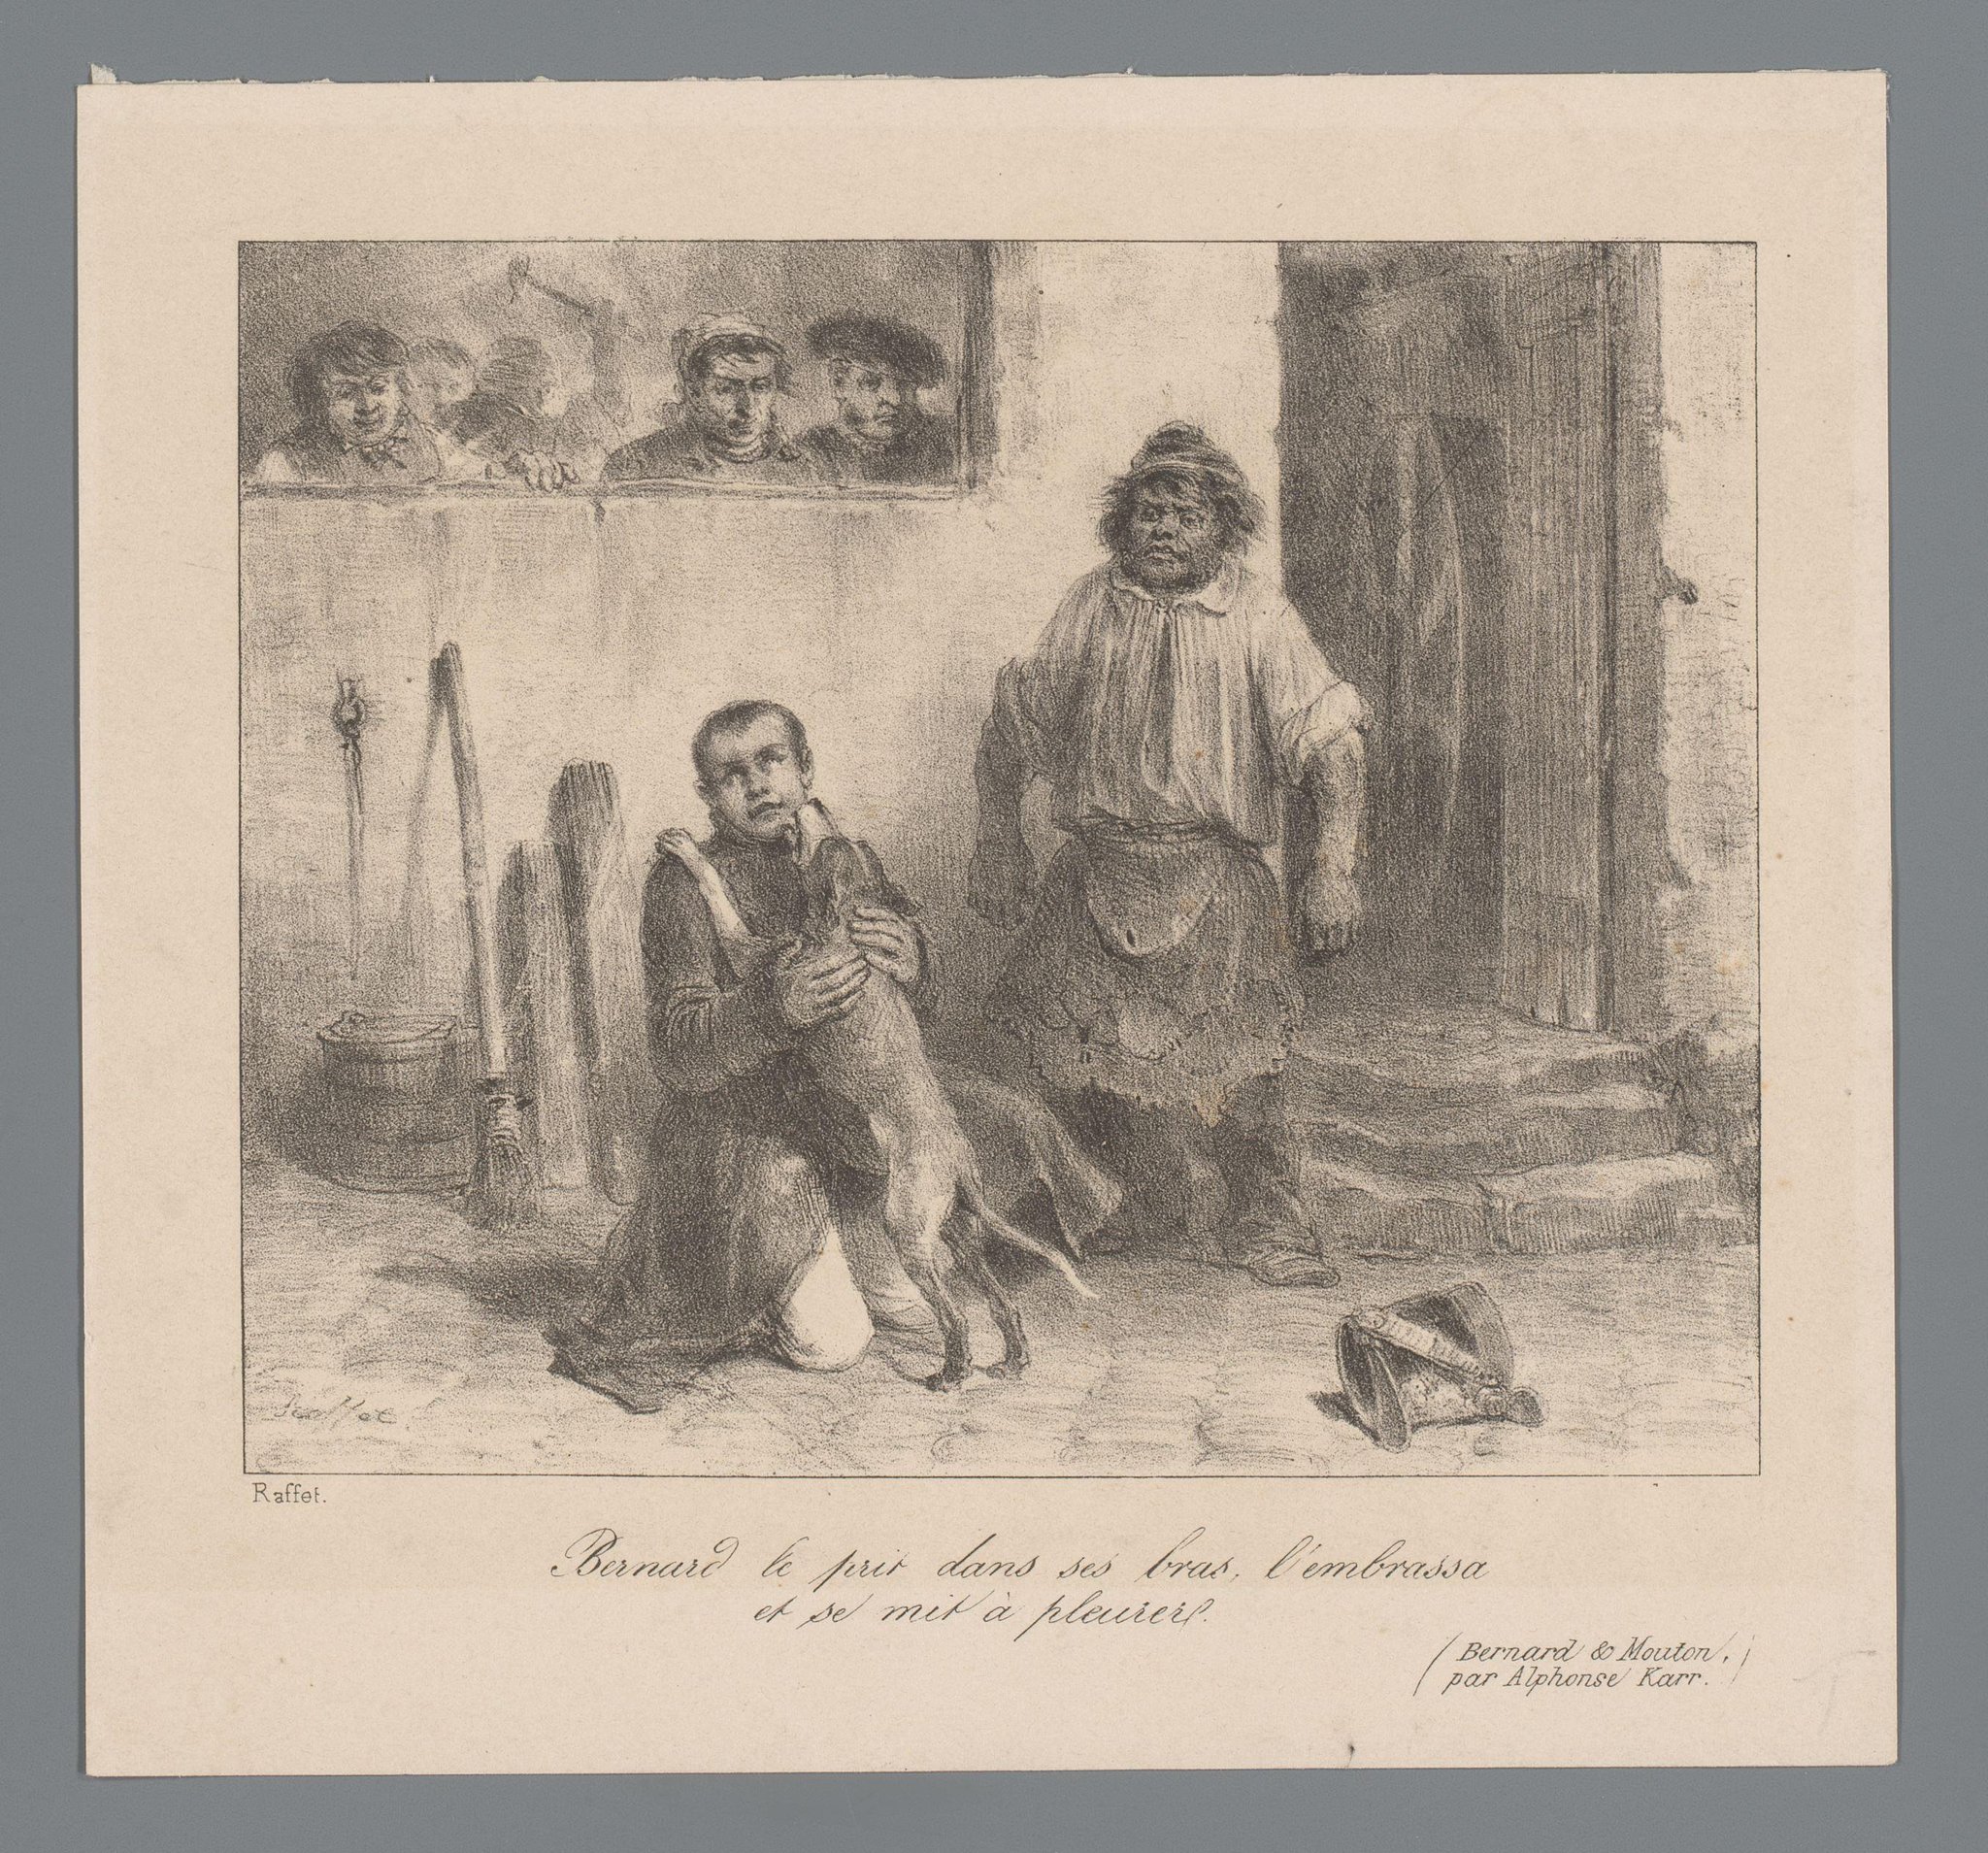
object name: print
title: Bernard le prit dans ses bras, l'embrassa et se mit à pleurer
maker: denis auguste marie raffet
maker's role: draughtsman, print maker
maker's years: 1804-1860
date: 1835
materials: paper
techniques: lithograph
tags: weeping, dog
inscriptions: collector's mark: Lugt 2228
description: Prent gebruikt in: L'Artiste, 1835, dl. 9.